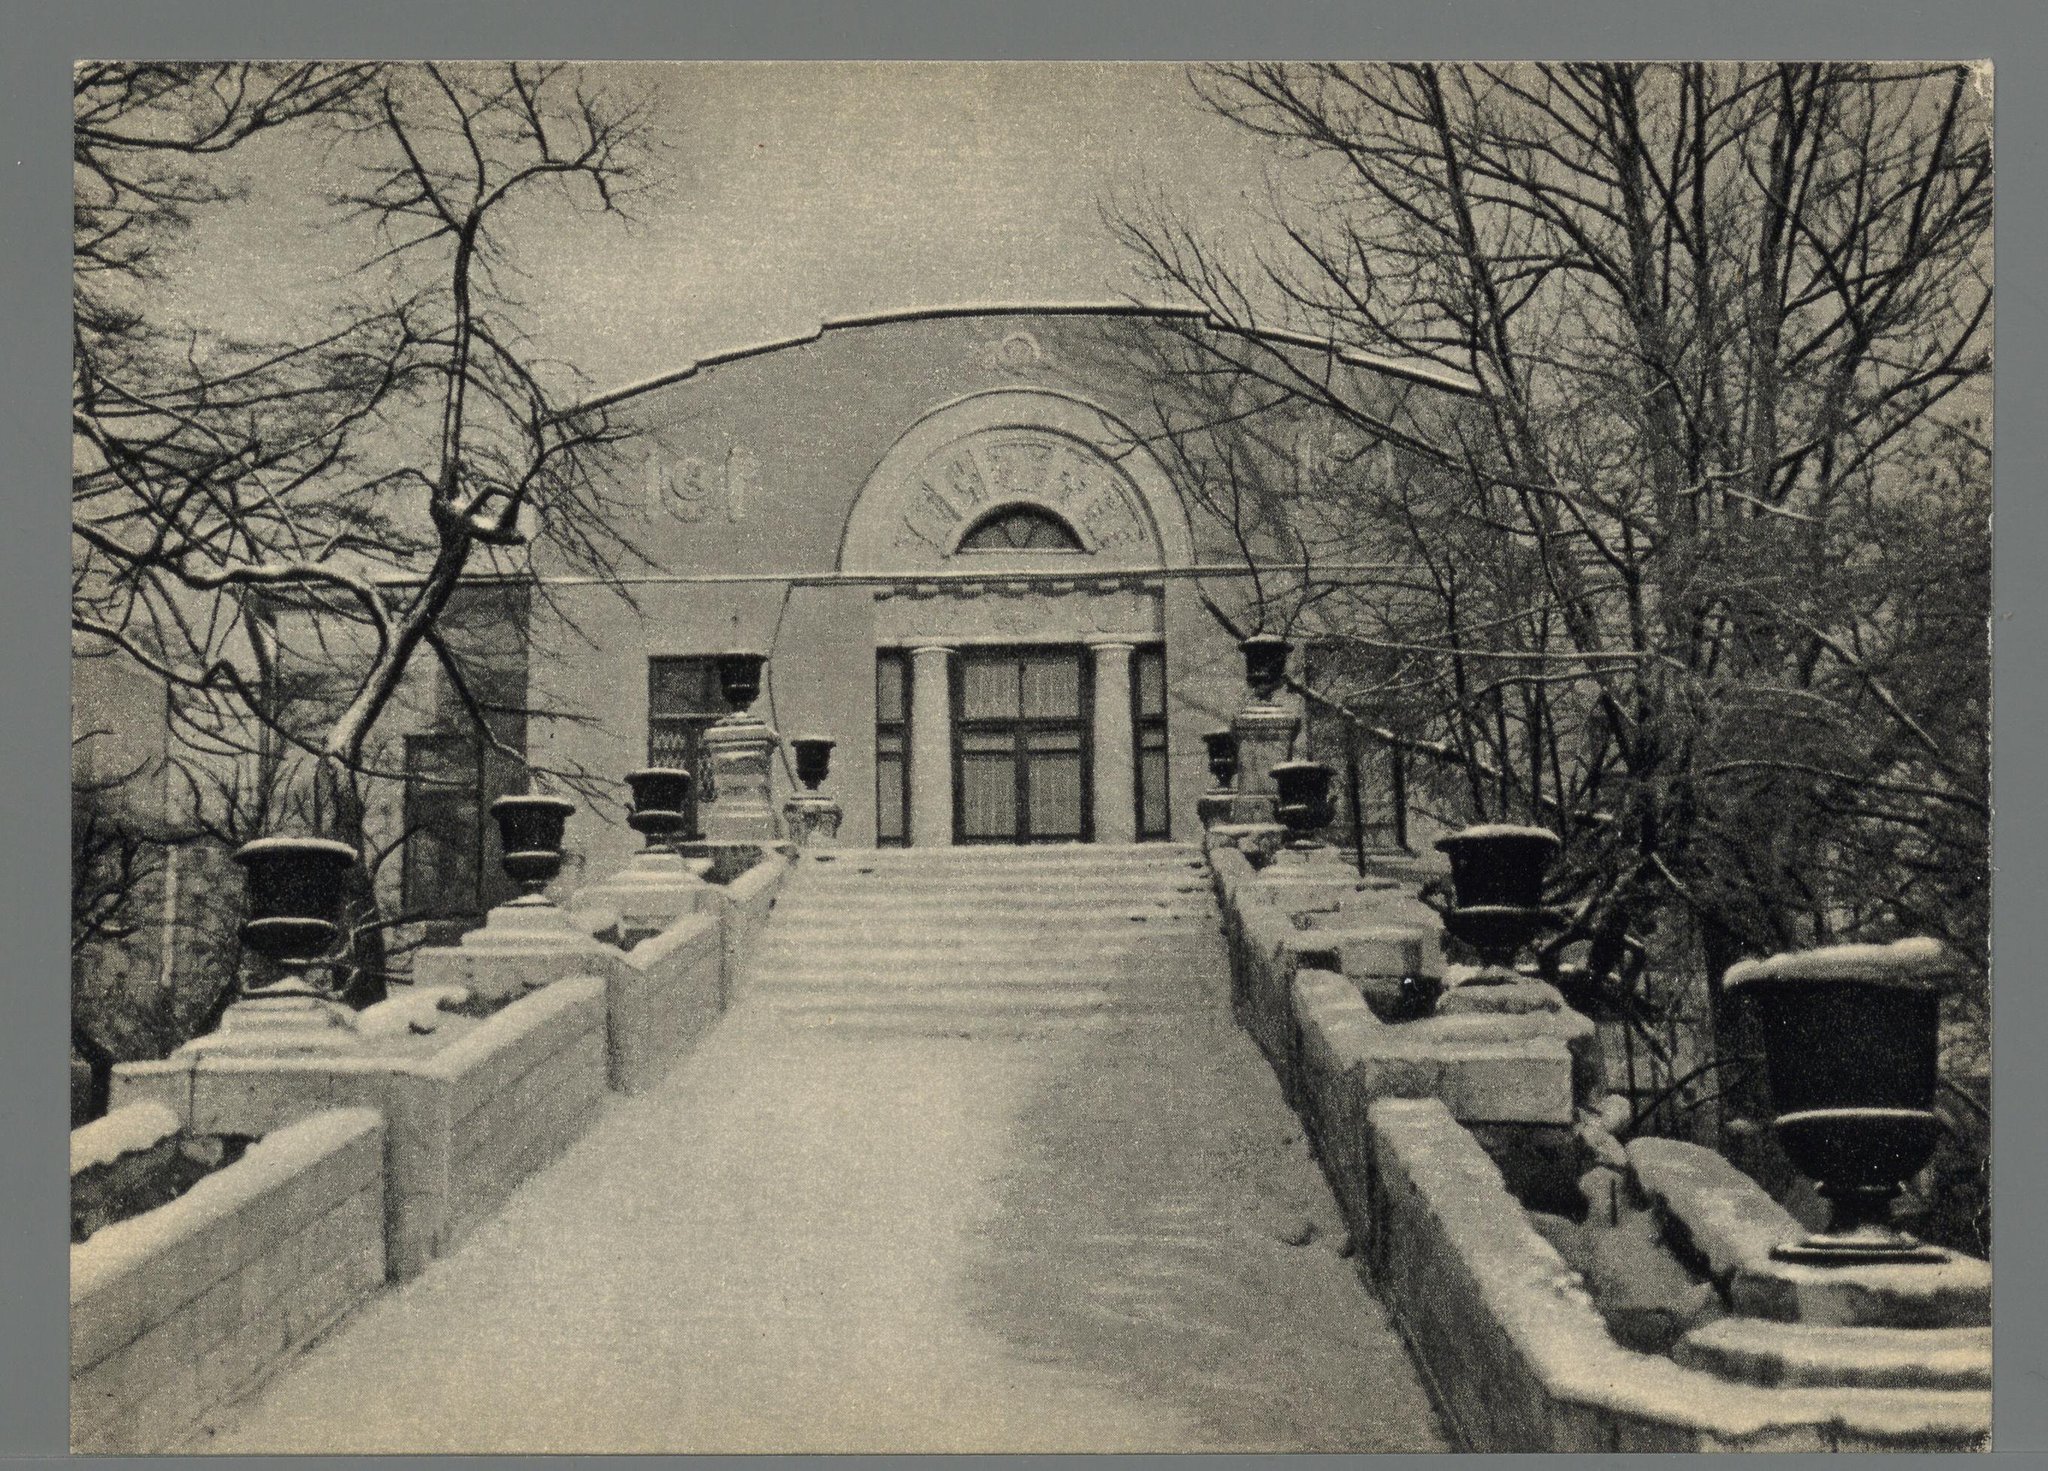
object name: photomechanical print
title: Gezicht op het sanatorium te Moskou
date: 1957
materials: cardboard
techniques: rotogravure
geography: moscow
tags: hospital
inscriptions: date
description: De titel op object staat in het Russisch.